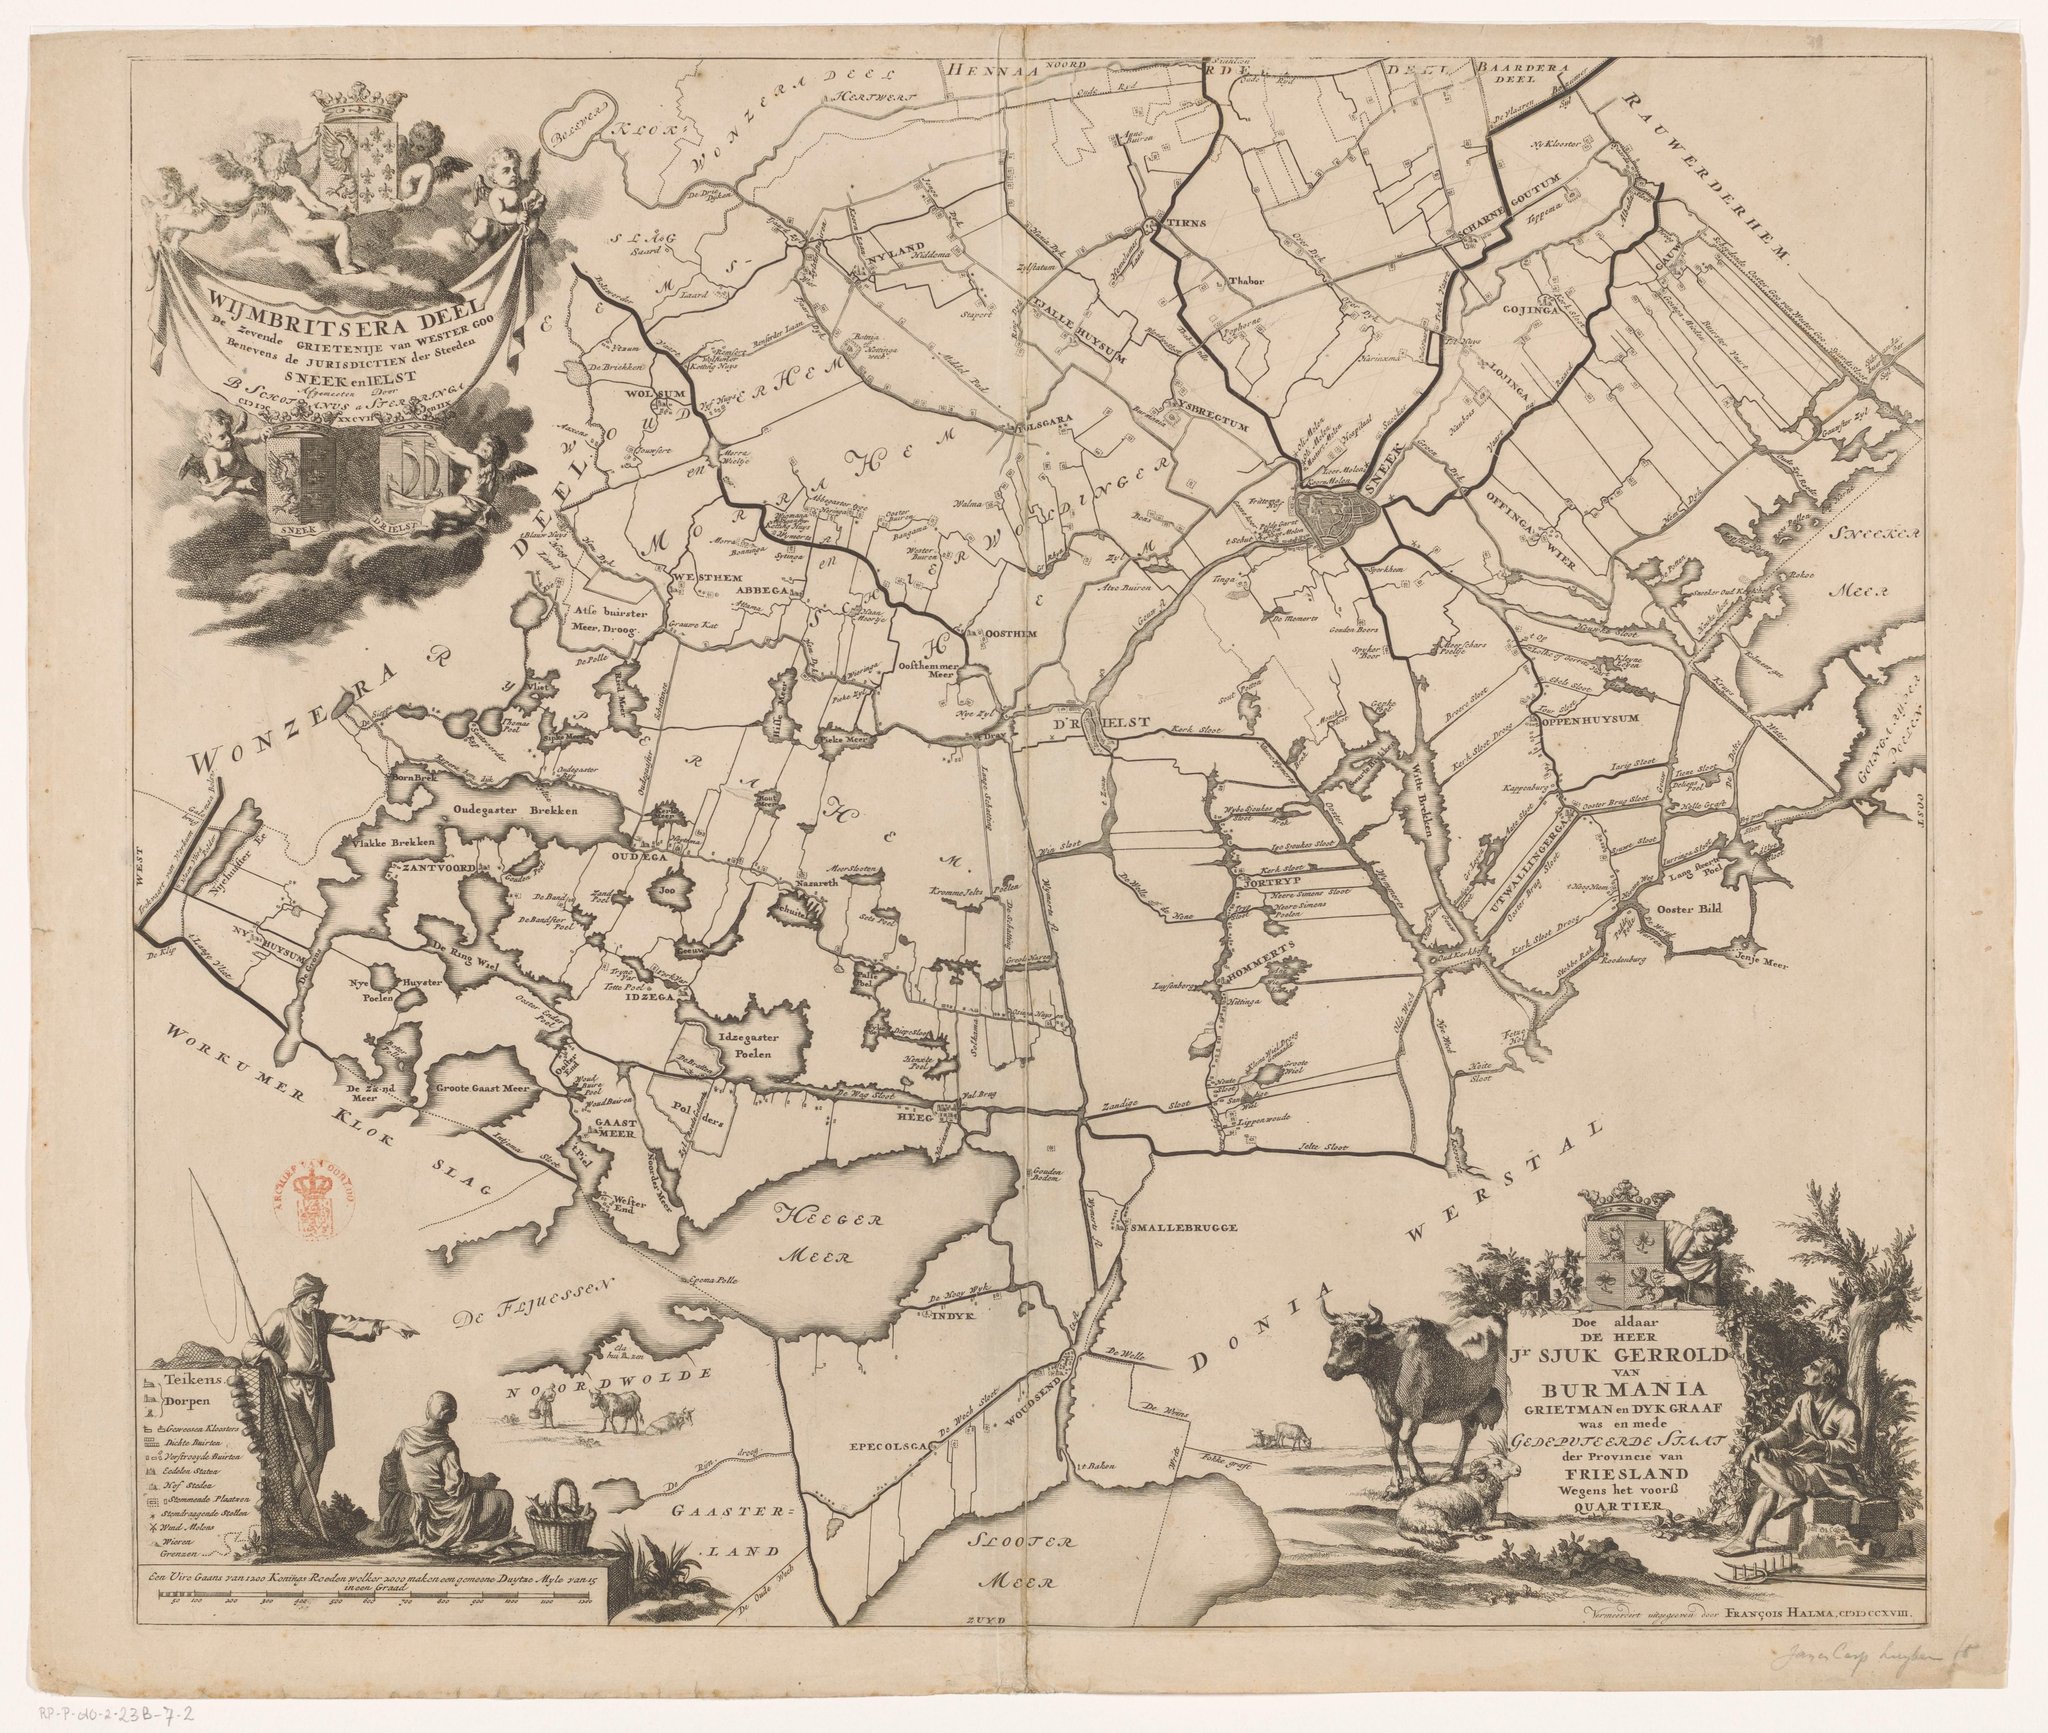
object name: print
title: Kaart van de grietenij Wymbritseradeel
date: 1698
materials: paper, pencil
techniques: engraving, etching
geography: leeuwarden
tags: coat of arms (as symbol of the state, etc.), maps of separate countries or regions, farmers, fisherman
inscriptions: collector's mark: Lugt 19, collector's mark: Lugt 19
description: Linksboven titelcartouche met daaromheen putti met de wapens van Wymbritseradeel, Sneek en IJlst. Linksonder legenda en een schaalstok: Een uire gaans van 1200 konings roeden, welker 2000 maken een gemeene Duytze myle van 15 in een graad. Daaromheen een visserman en -vrouw. Rechtsonder cartouche met bestuurlijke informatie over de grietenij, daaromheen het wapen van grietman jonker Sjuk Gerrold van Burmania, vee een man en een landbouwer. Met rooster.